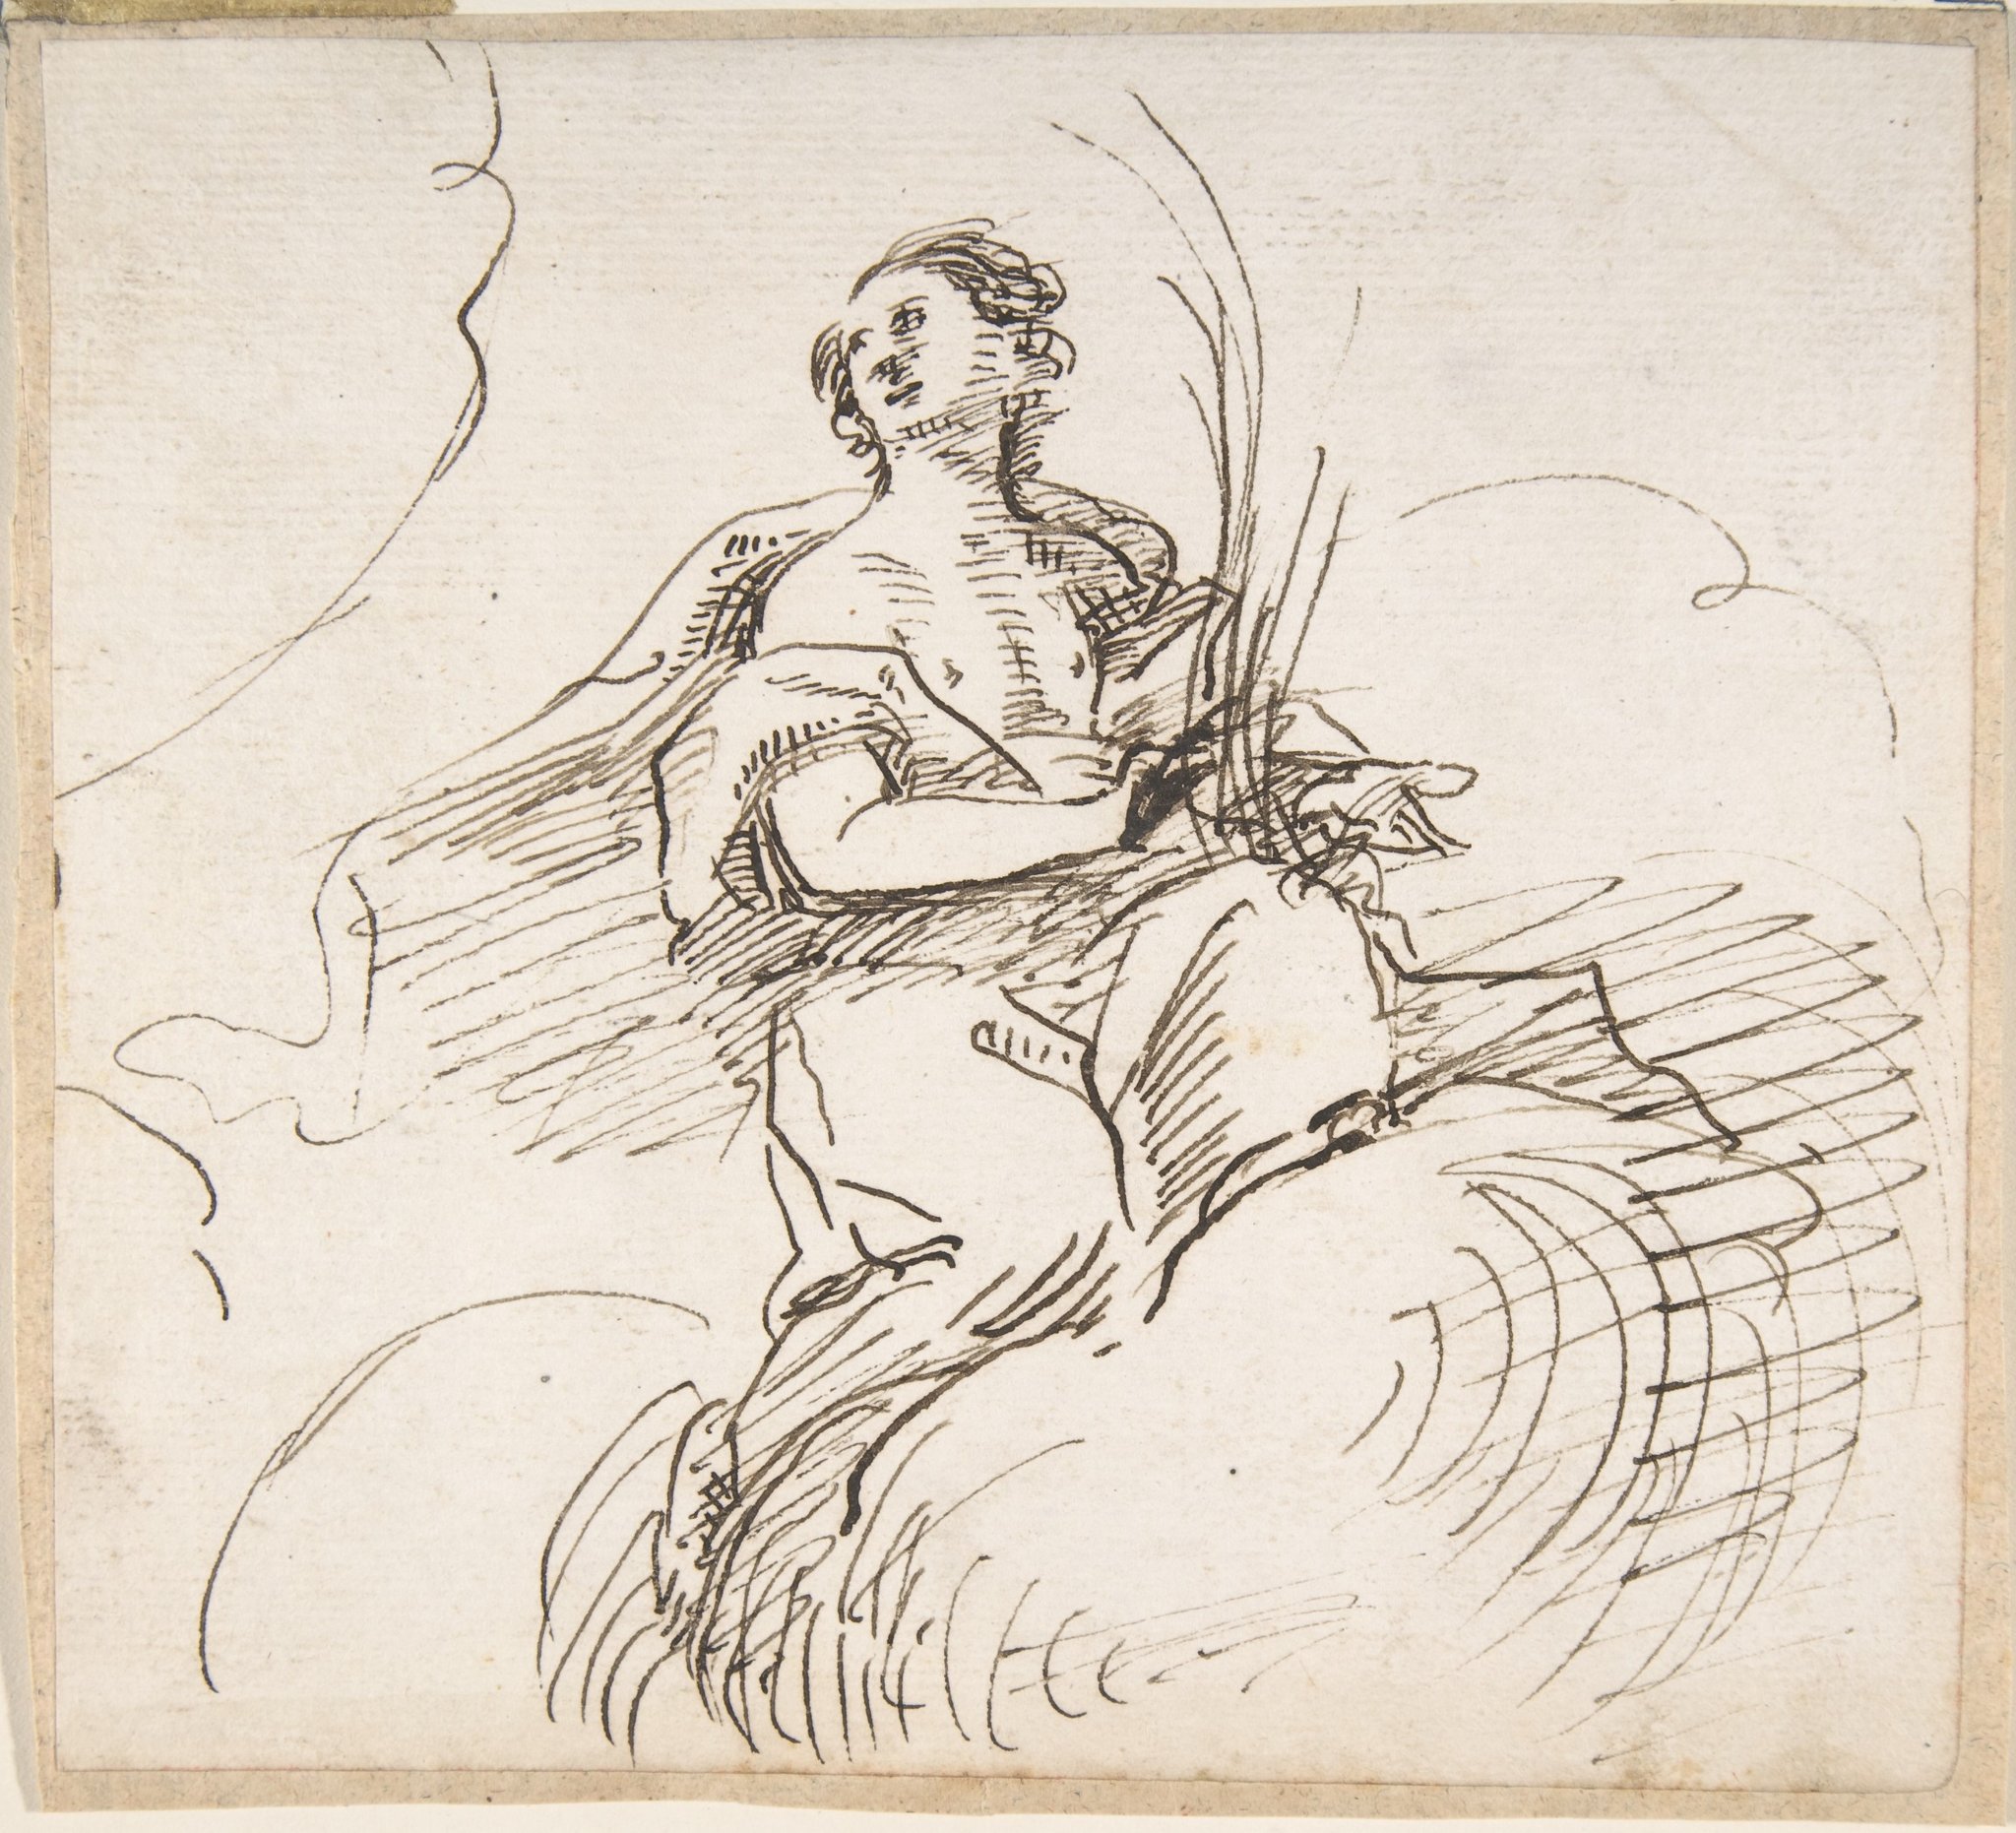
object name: drawing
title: Angel with Palm Seated on Clouds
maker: pedro duque cornejo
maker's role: artist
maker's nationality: spanish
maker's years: 1677-1757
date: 1700-1750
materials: ink, paper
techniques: pen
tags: angels